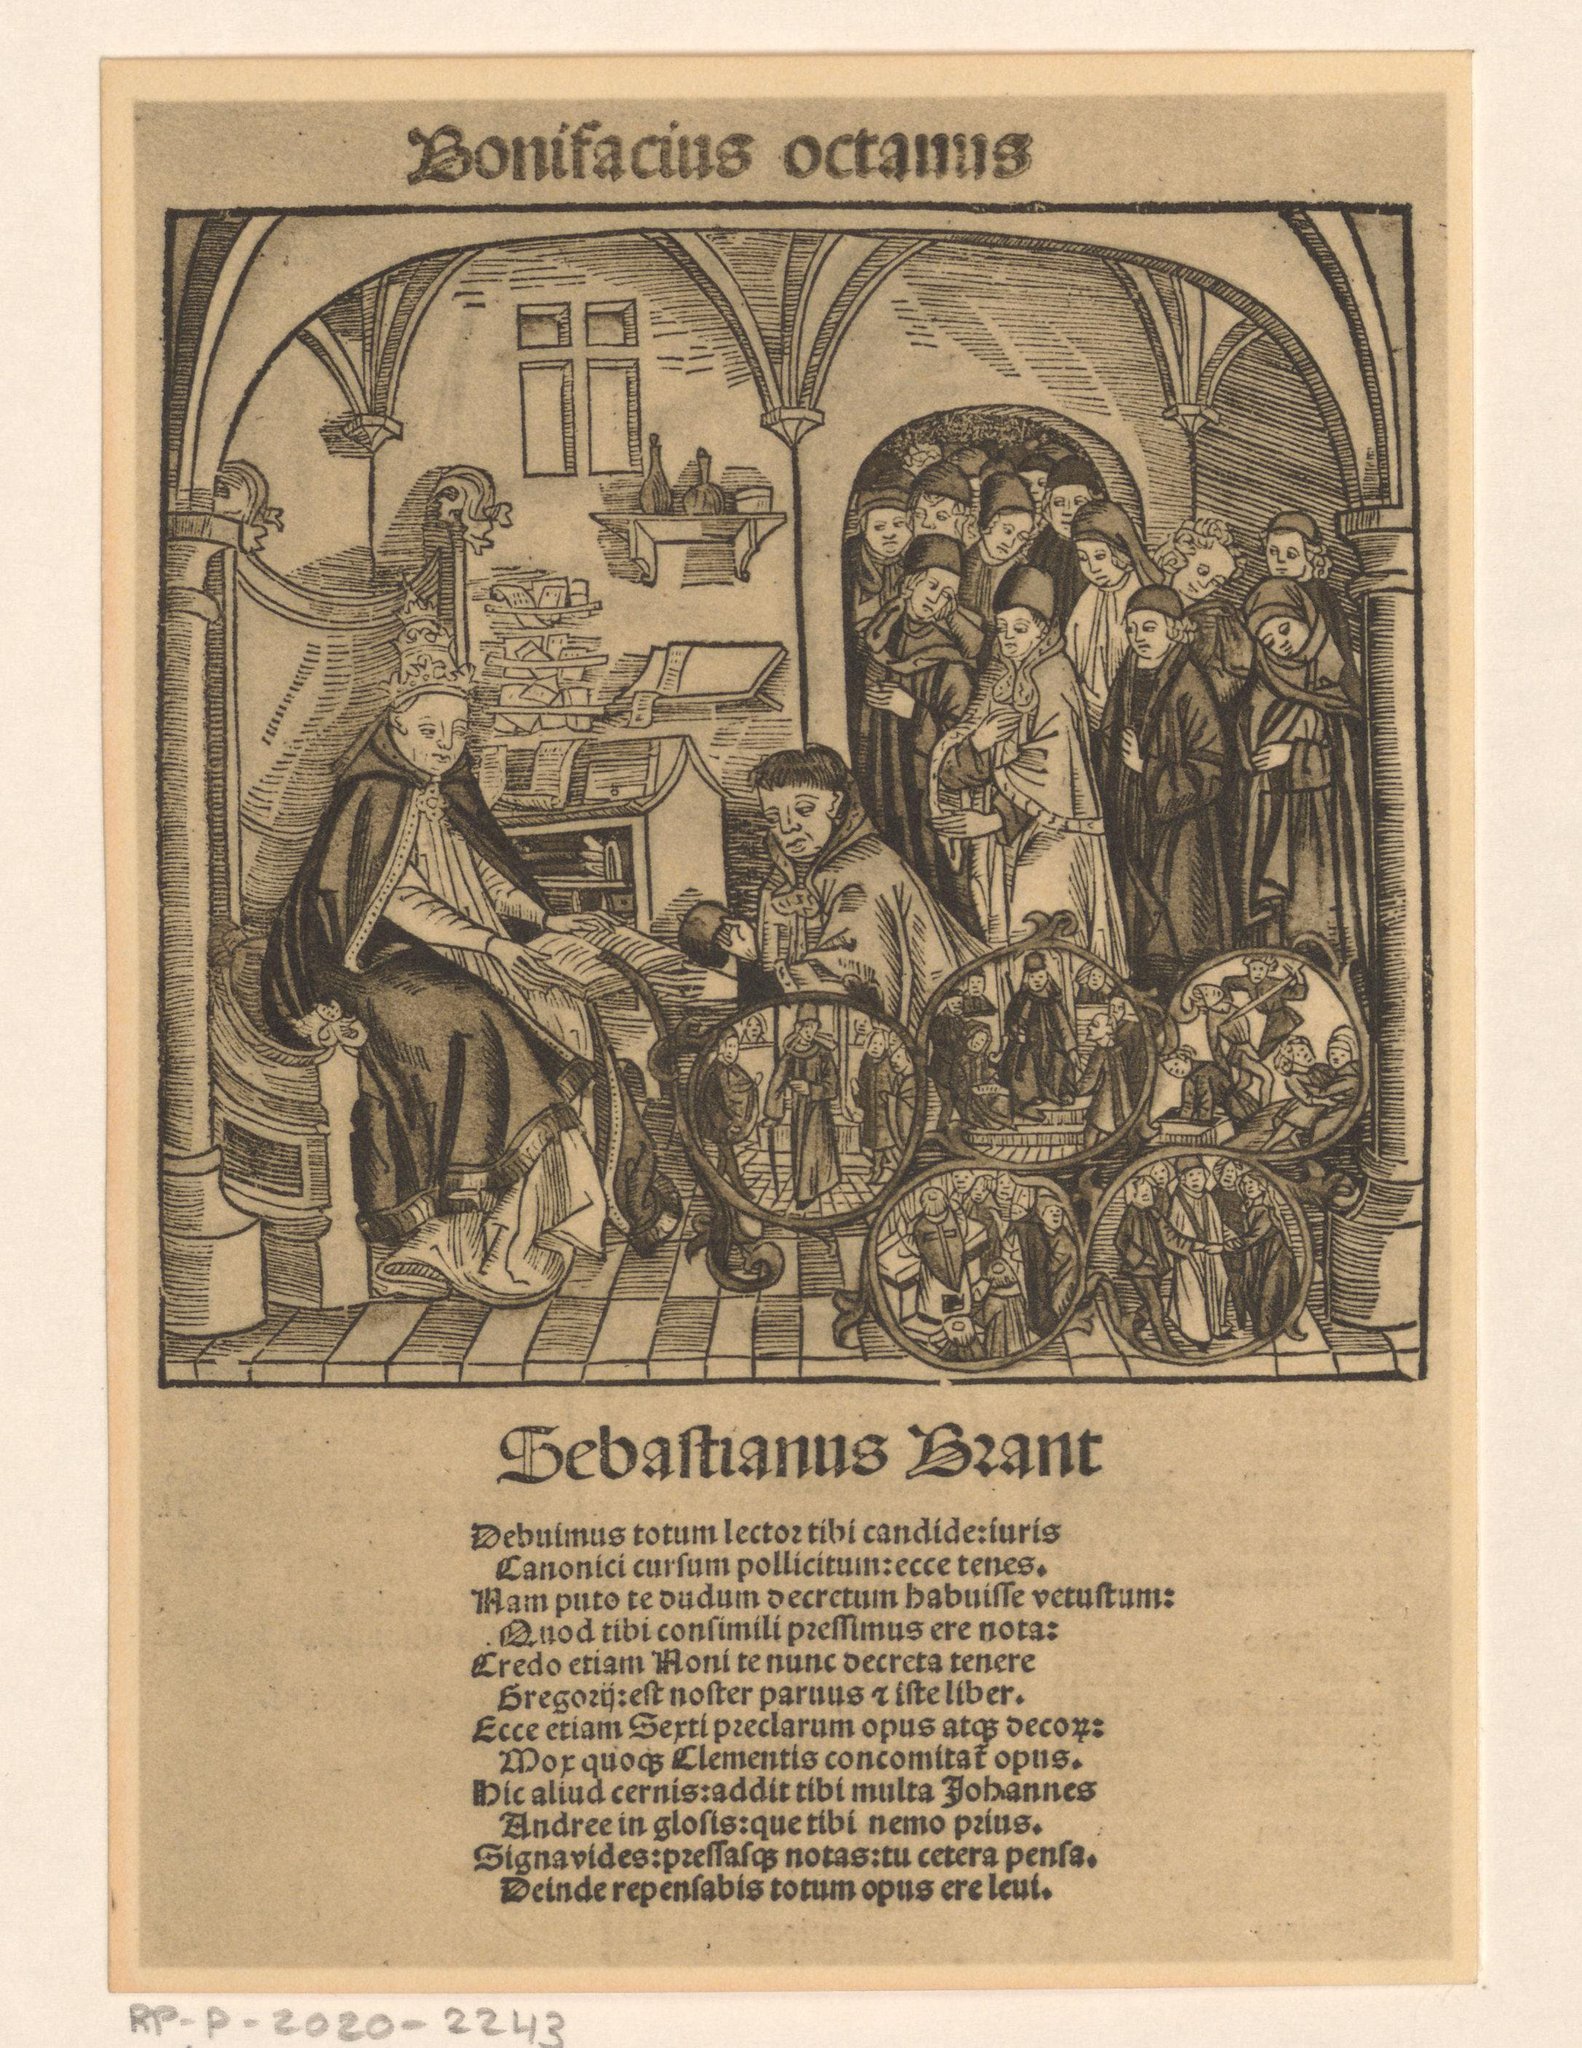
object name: photomechanical print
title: Audiëntie van paus Bonifatius VIII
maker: Anonymous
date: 1875-1930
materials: paper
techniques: photograph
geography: leiden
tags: rome, historical persons, pope giving an audience, pope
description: Naar een prent uit: Brant, Sebastian. Corpus juris canonici glossatum. Basel: Johann Amerbach et Johann Froben, 1500.